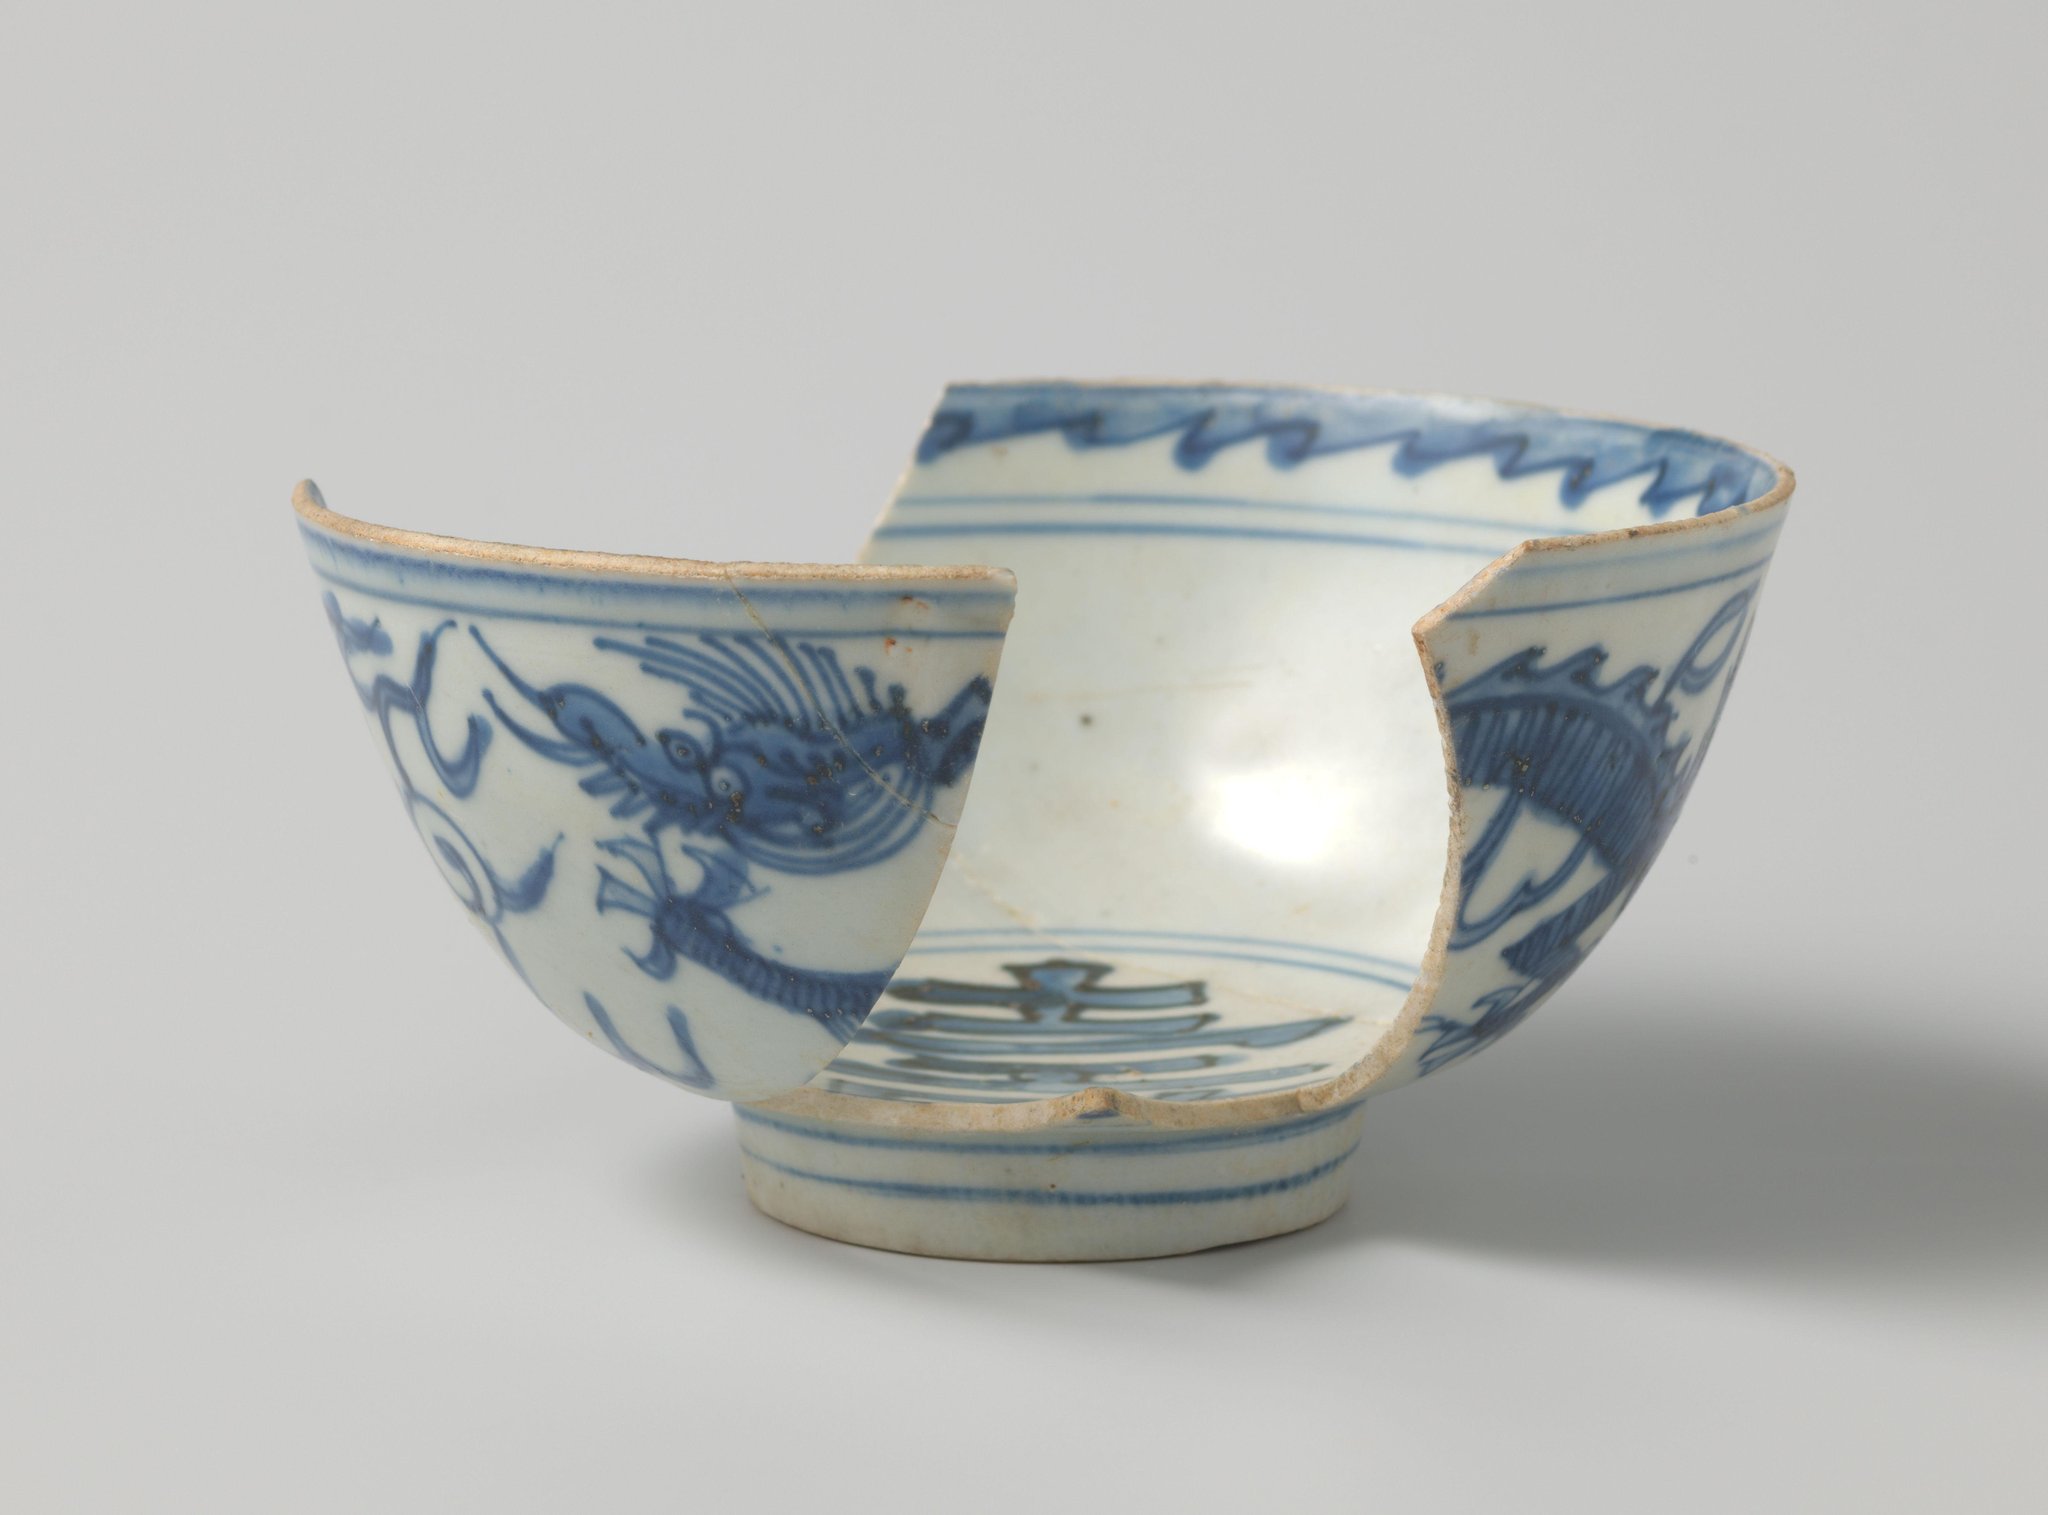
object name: bowl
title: Fragment kom uit V.O.C.-schip de 'Witte Leeuw'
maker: Anonymous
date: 1613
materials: porcelain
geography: jingdezhen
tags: verenigde oostindische compagnie, sint-helena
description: A bowl. The cobalt blue is of a dark purple colour. In the centre the character for a long life: shou is drawn, encircled by a double band. On the lip-rim a stylized wave band is drawn. The outside wall is decorated with two four-clawed dragons chasing a flaming pearl.